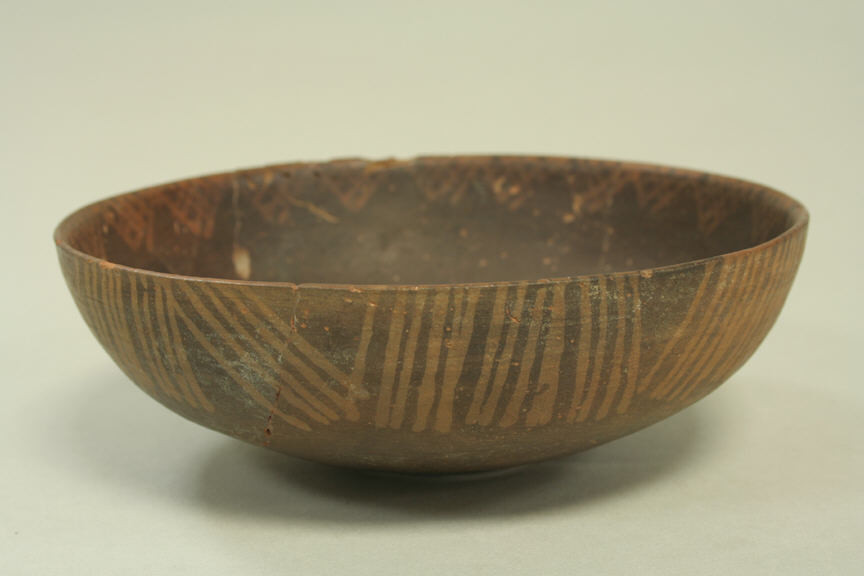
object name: bowl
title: Orangeware Bowl with Lines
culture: paracas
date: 300-201 BCE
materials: ceramic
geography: peru